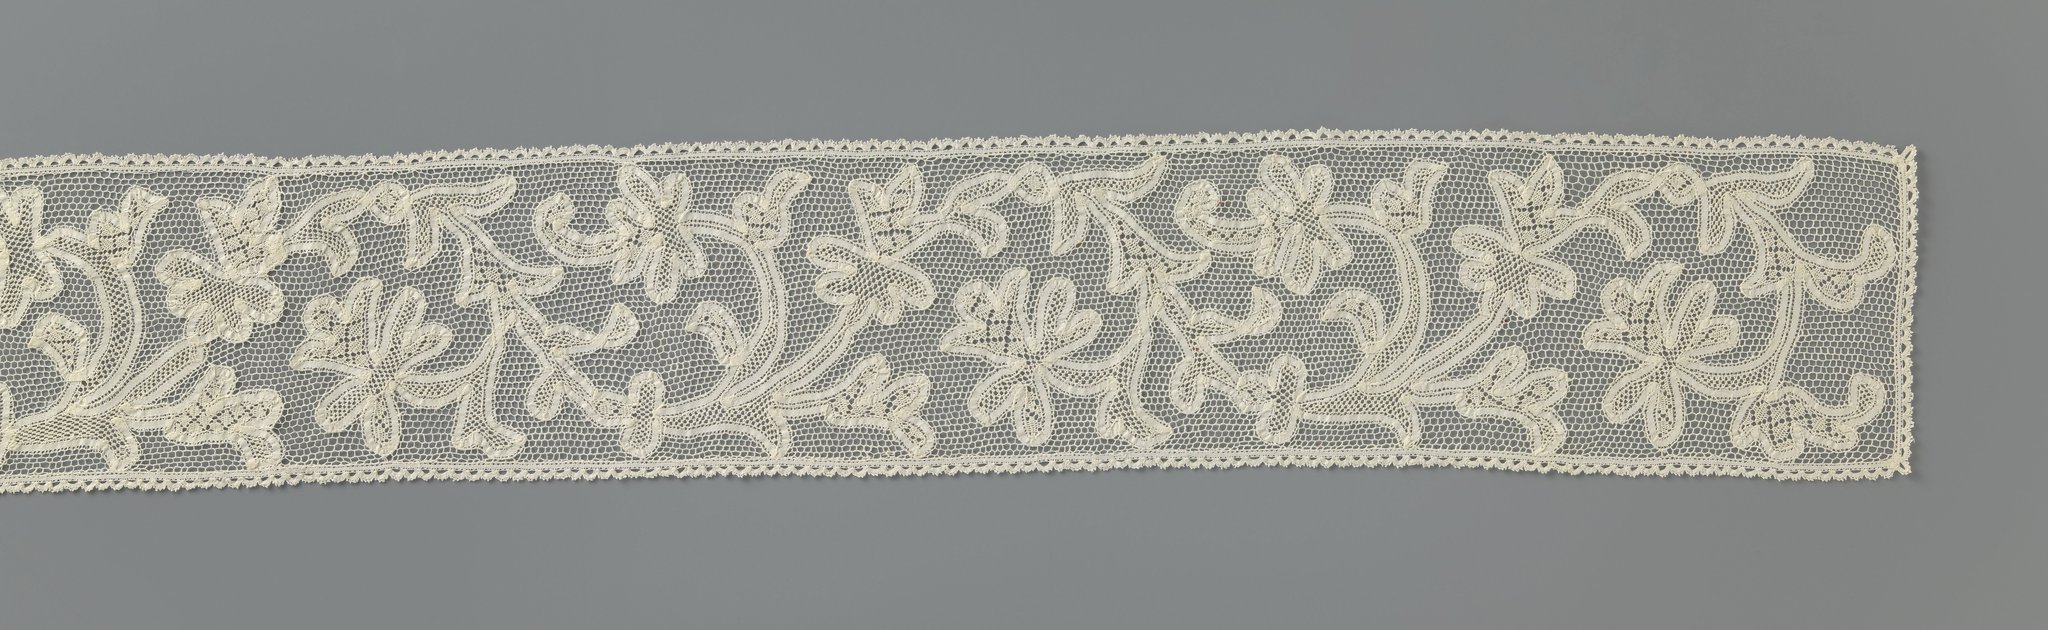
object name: strip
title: Strook gemengde kant met brede spiraalrank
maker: Anonymous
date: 1690-1699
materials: linen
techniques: lace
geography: milan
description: Strook naturelkleurige gemengde kant - mezzo punto - met een geklost of geweven lint en een naaldkantgrond. Op een maasgrond (naaldkant) staat een patroon dat bestaat uit brede omkrullende stengels met exotische bloemen. De contouren van de bloemen en stengels bestaan uit gekloste of geweven linten. Binnen de contouren zijn verschillende siergronden (naaldkant) toegepast. Een geklost boogjesrandje dient als afwerking langs de buitenzijden, met uitzondering van één korte zijde die is afgewerkt met een recht geklost bandje.